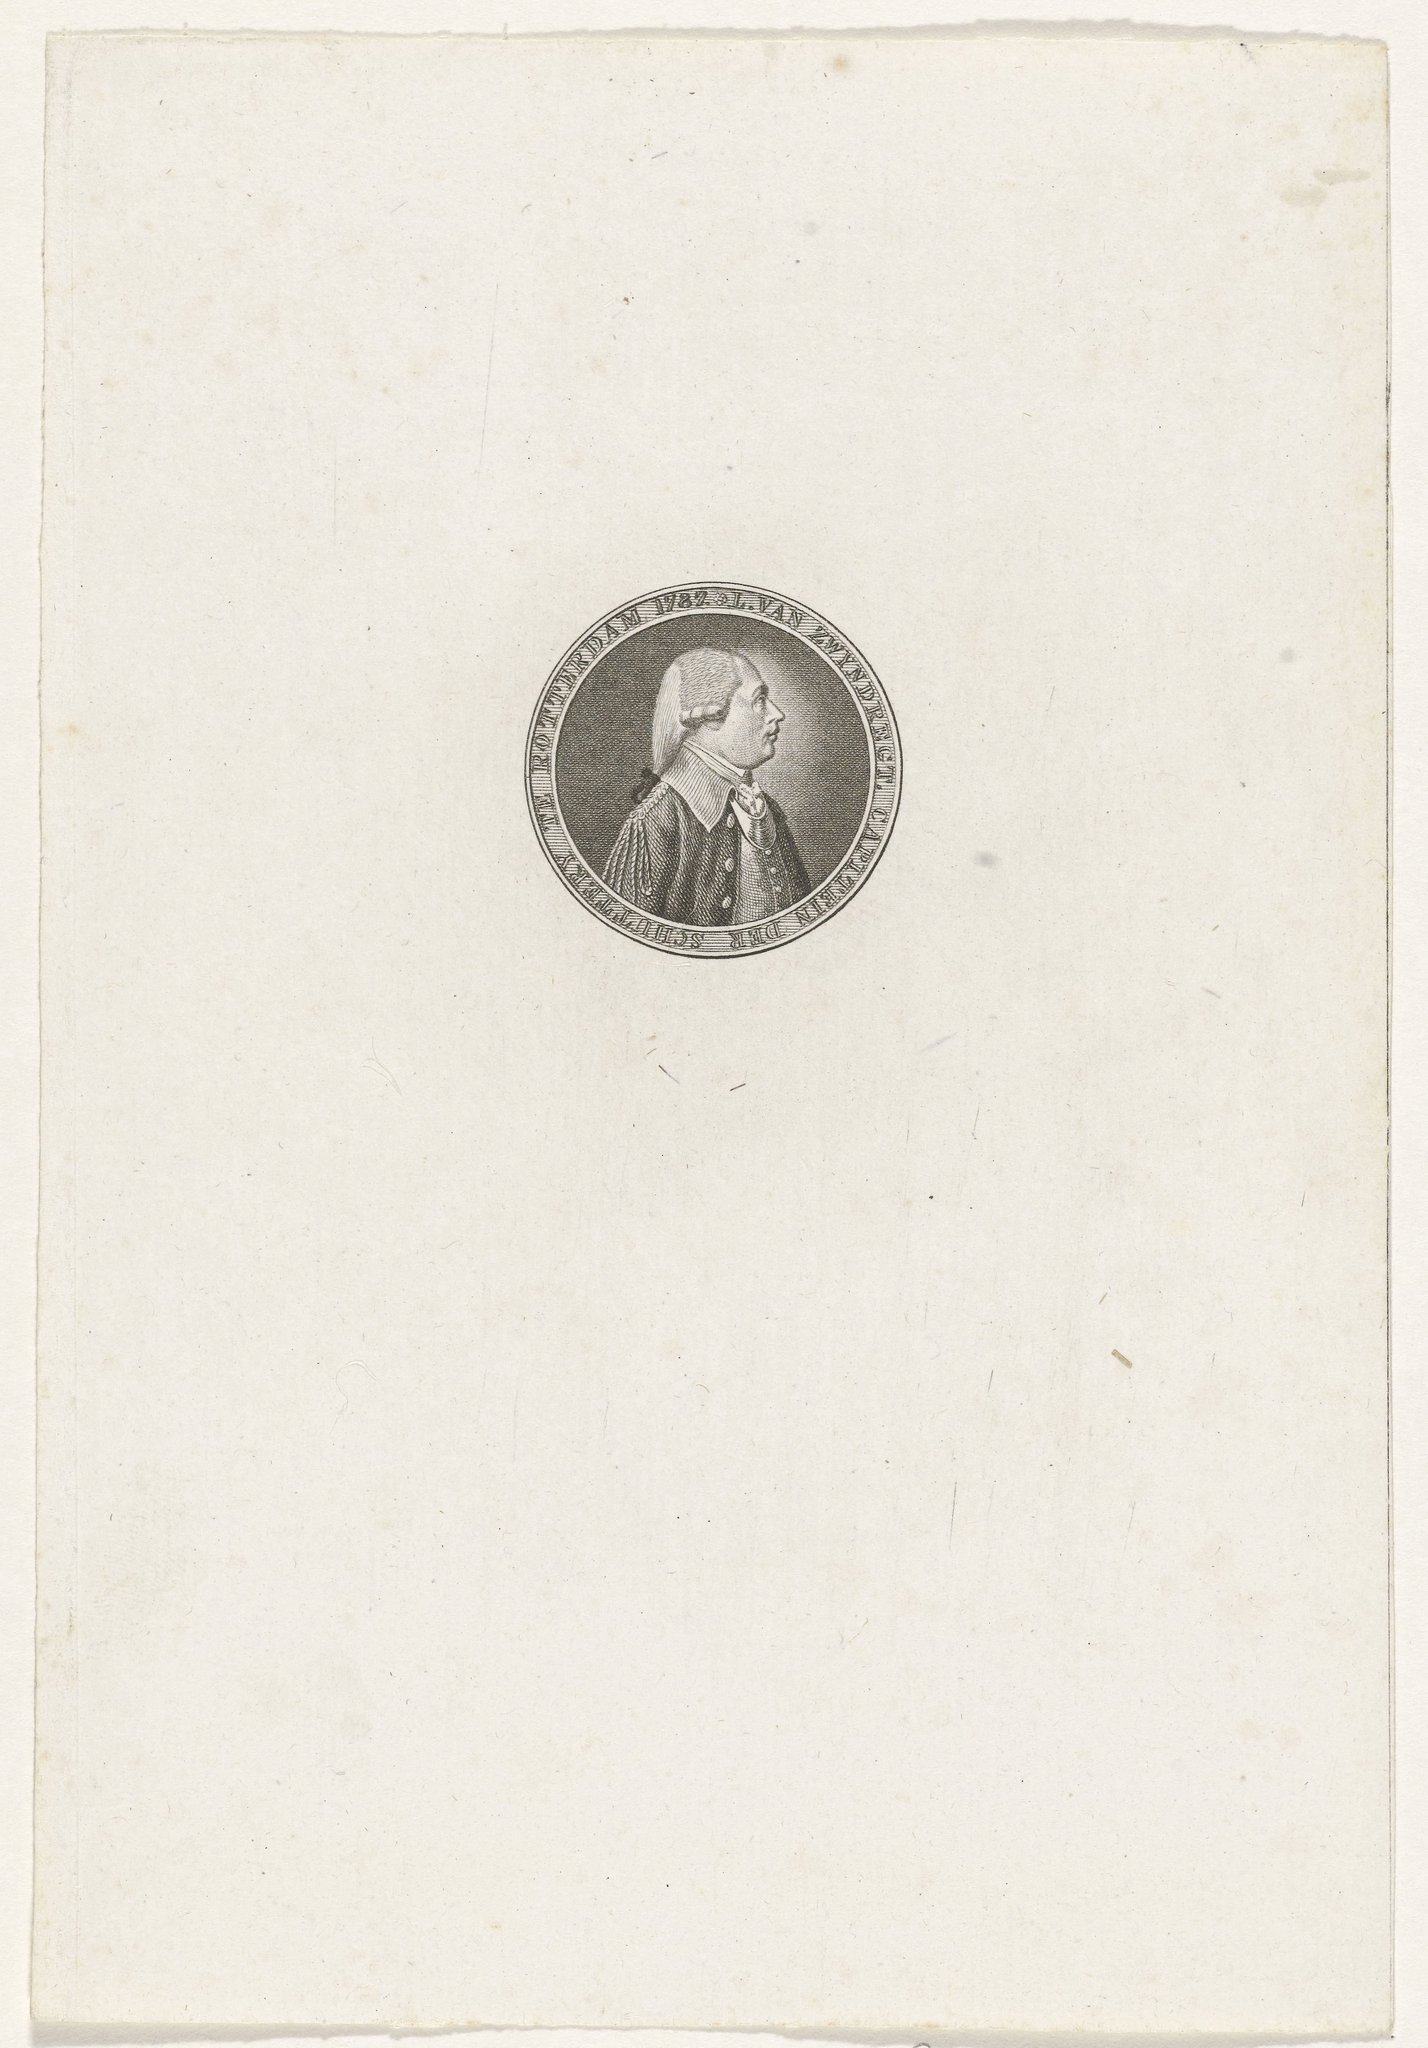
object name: print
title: Portret van Leendert van Zwyndrecht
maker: abraham jacobsz. hulk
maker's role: print maker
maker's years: 1751-1817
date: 1787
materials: paper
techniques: engraving, etching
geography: paris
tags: leendert van zwyndrecht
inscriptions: collector's mark: Lugt 2228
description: Buste van Leendert van Zwyndrecht en profil naar rechts in een medaillon met randschrift in het Nederlands.